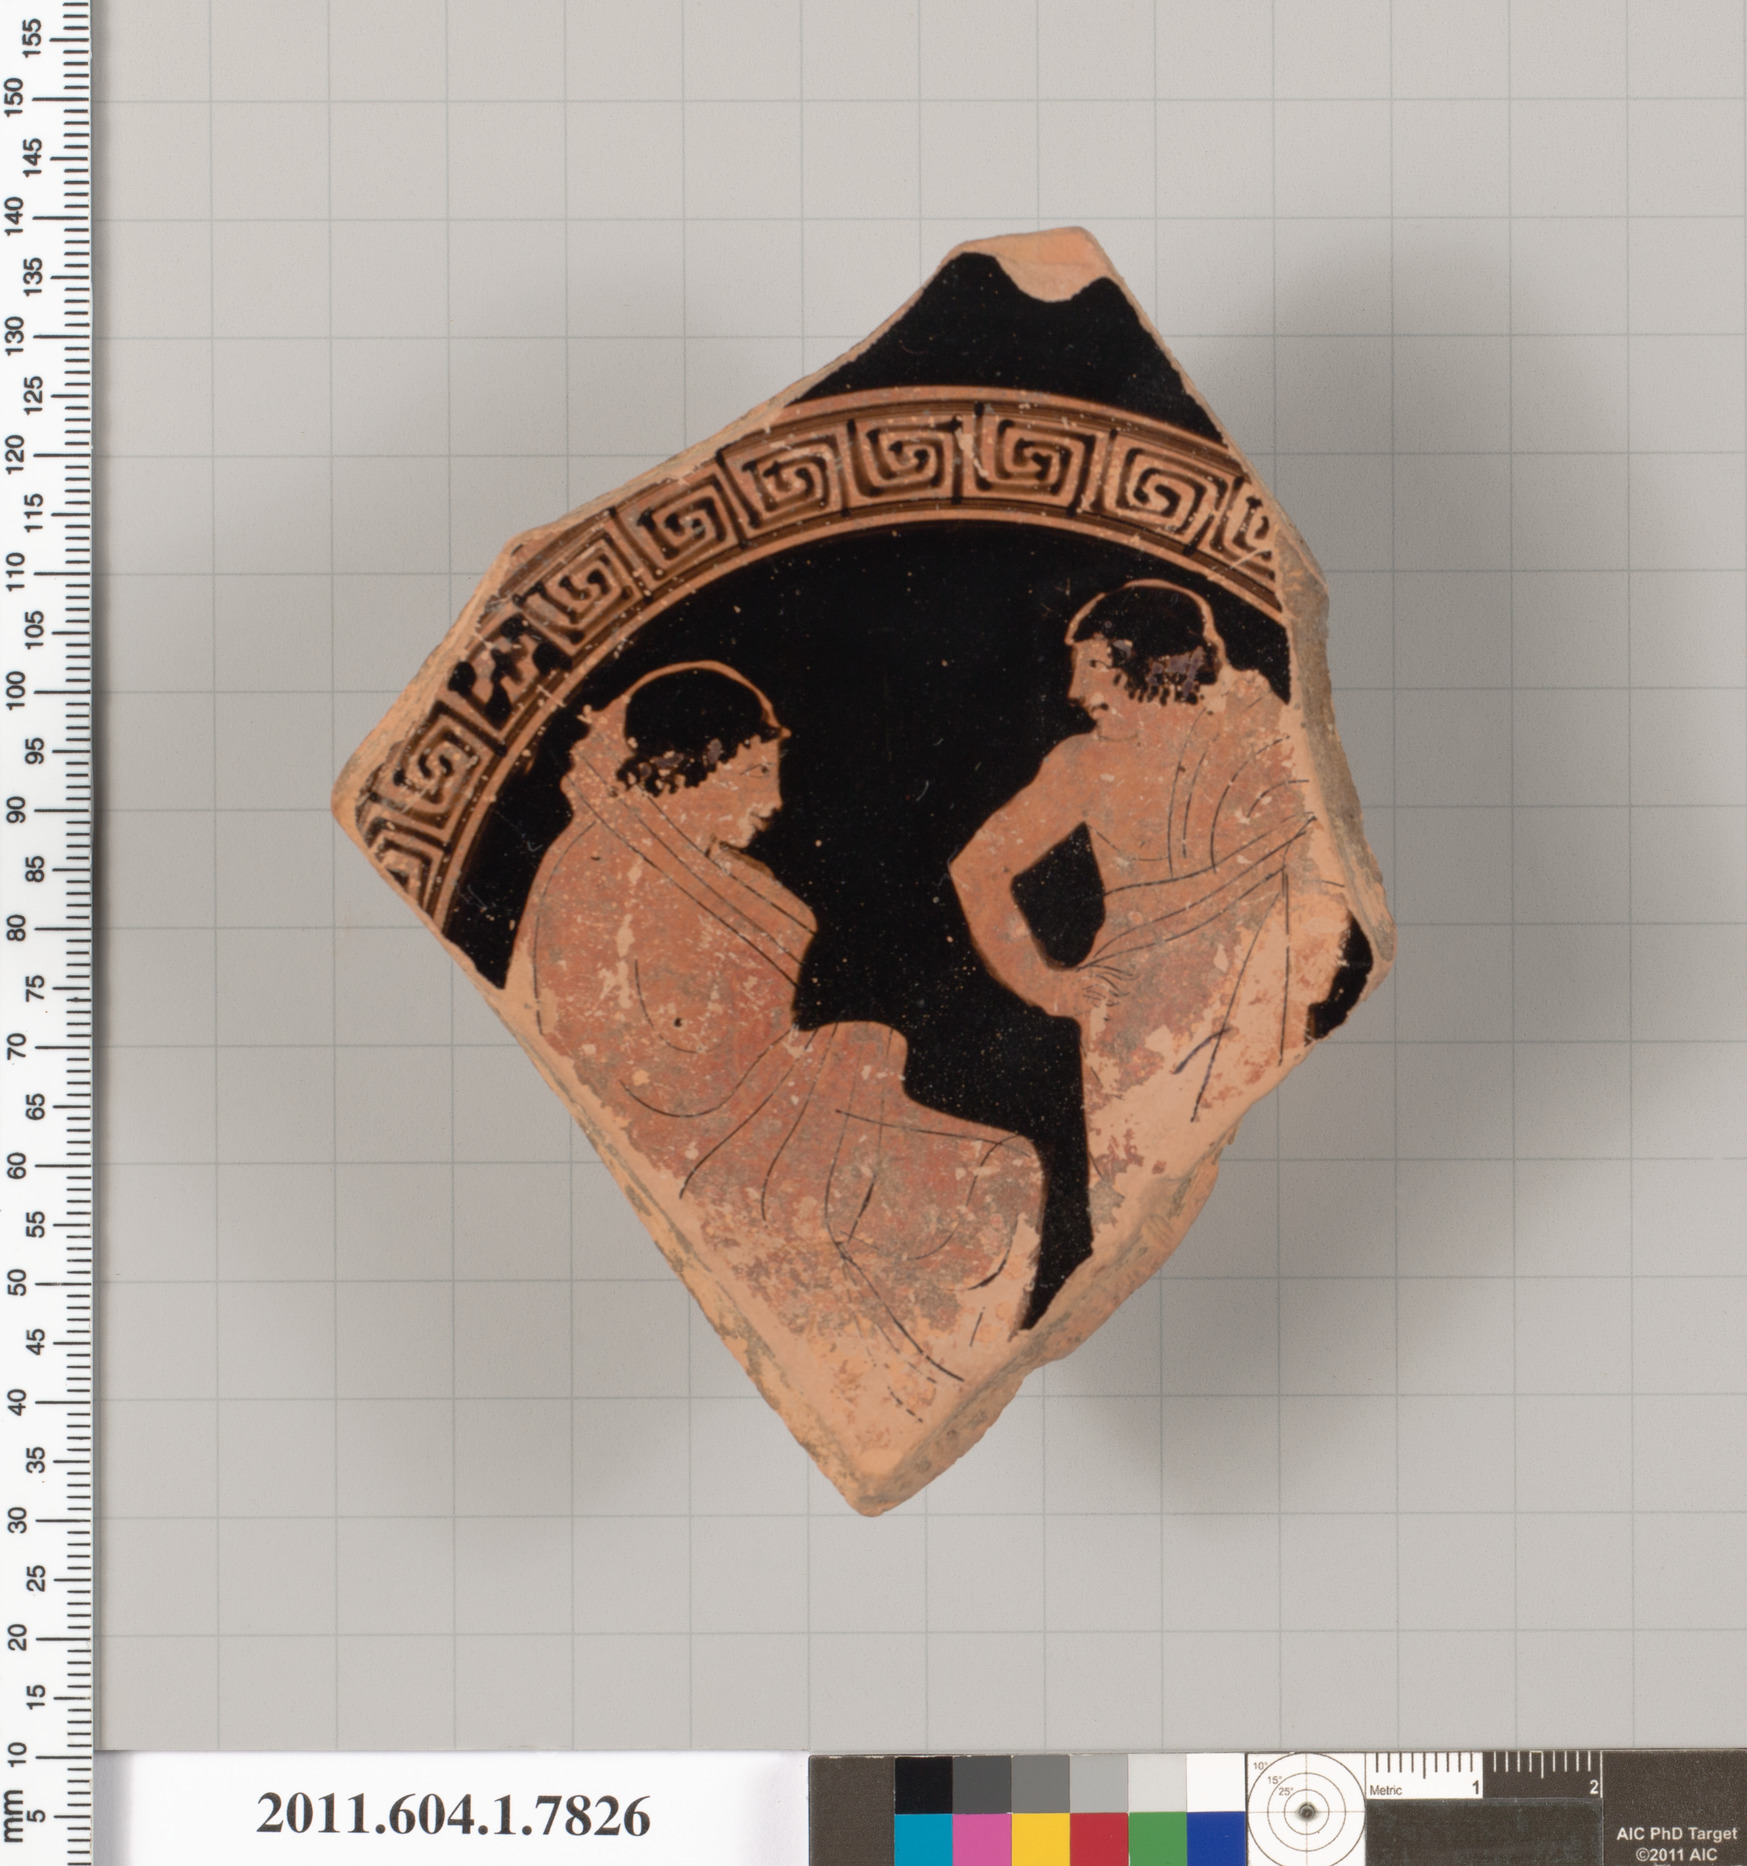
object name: kylix fragment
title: Terracotta fragment of a kylix (drinking cup)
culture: greek, attic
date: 460-450 BCE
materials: terracotta